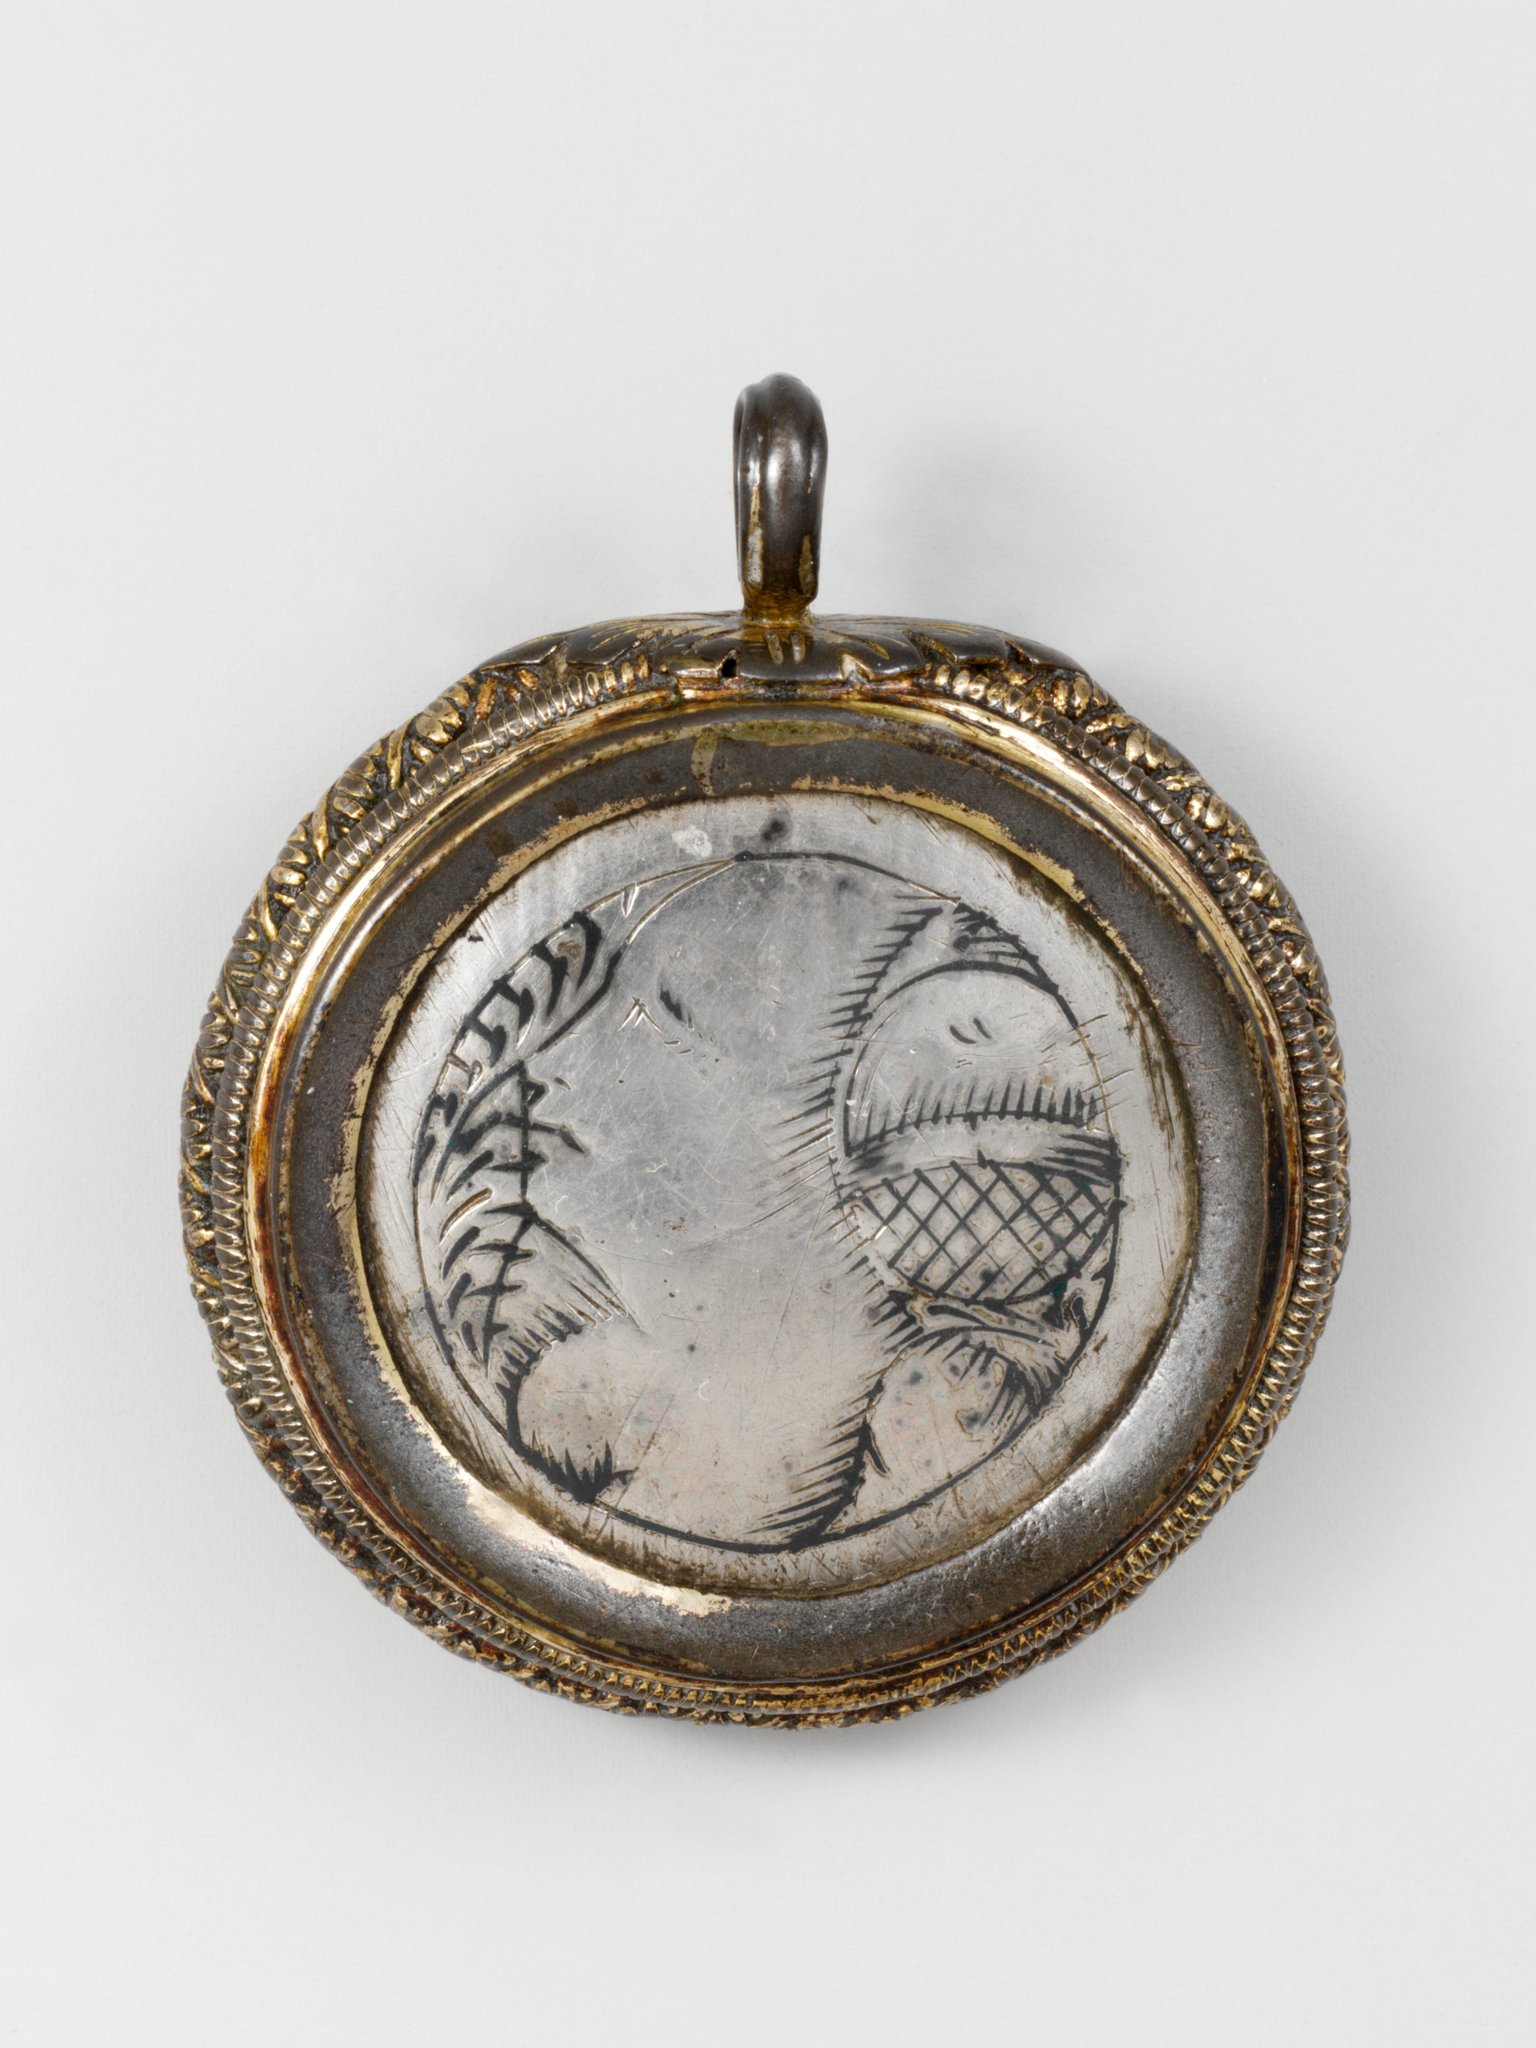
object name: pendant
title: Pendant (one of a pair)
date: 1451-1500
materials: silver gilt, niello, silver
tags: reliquaries